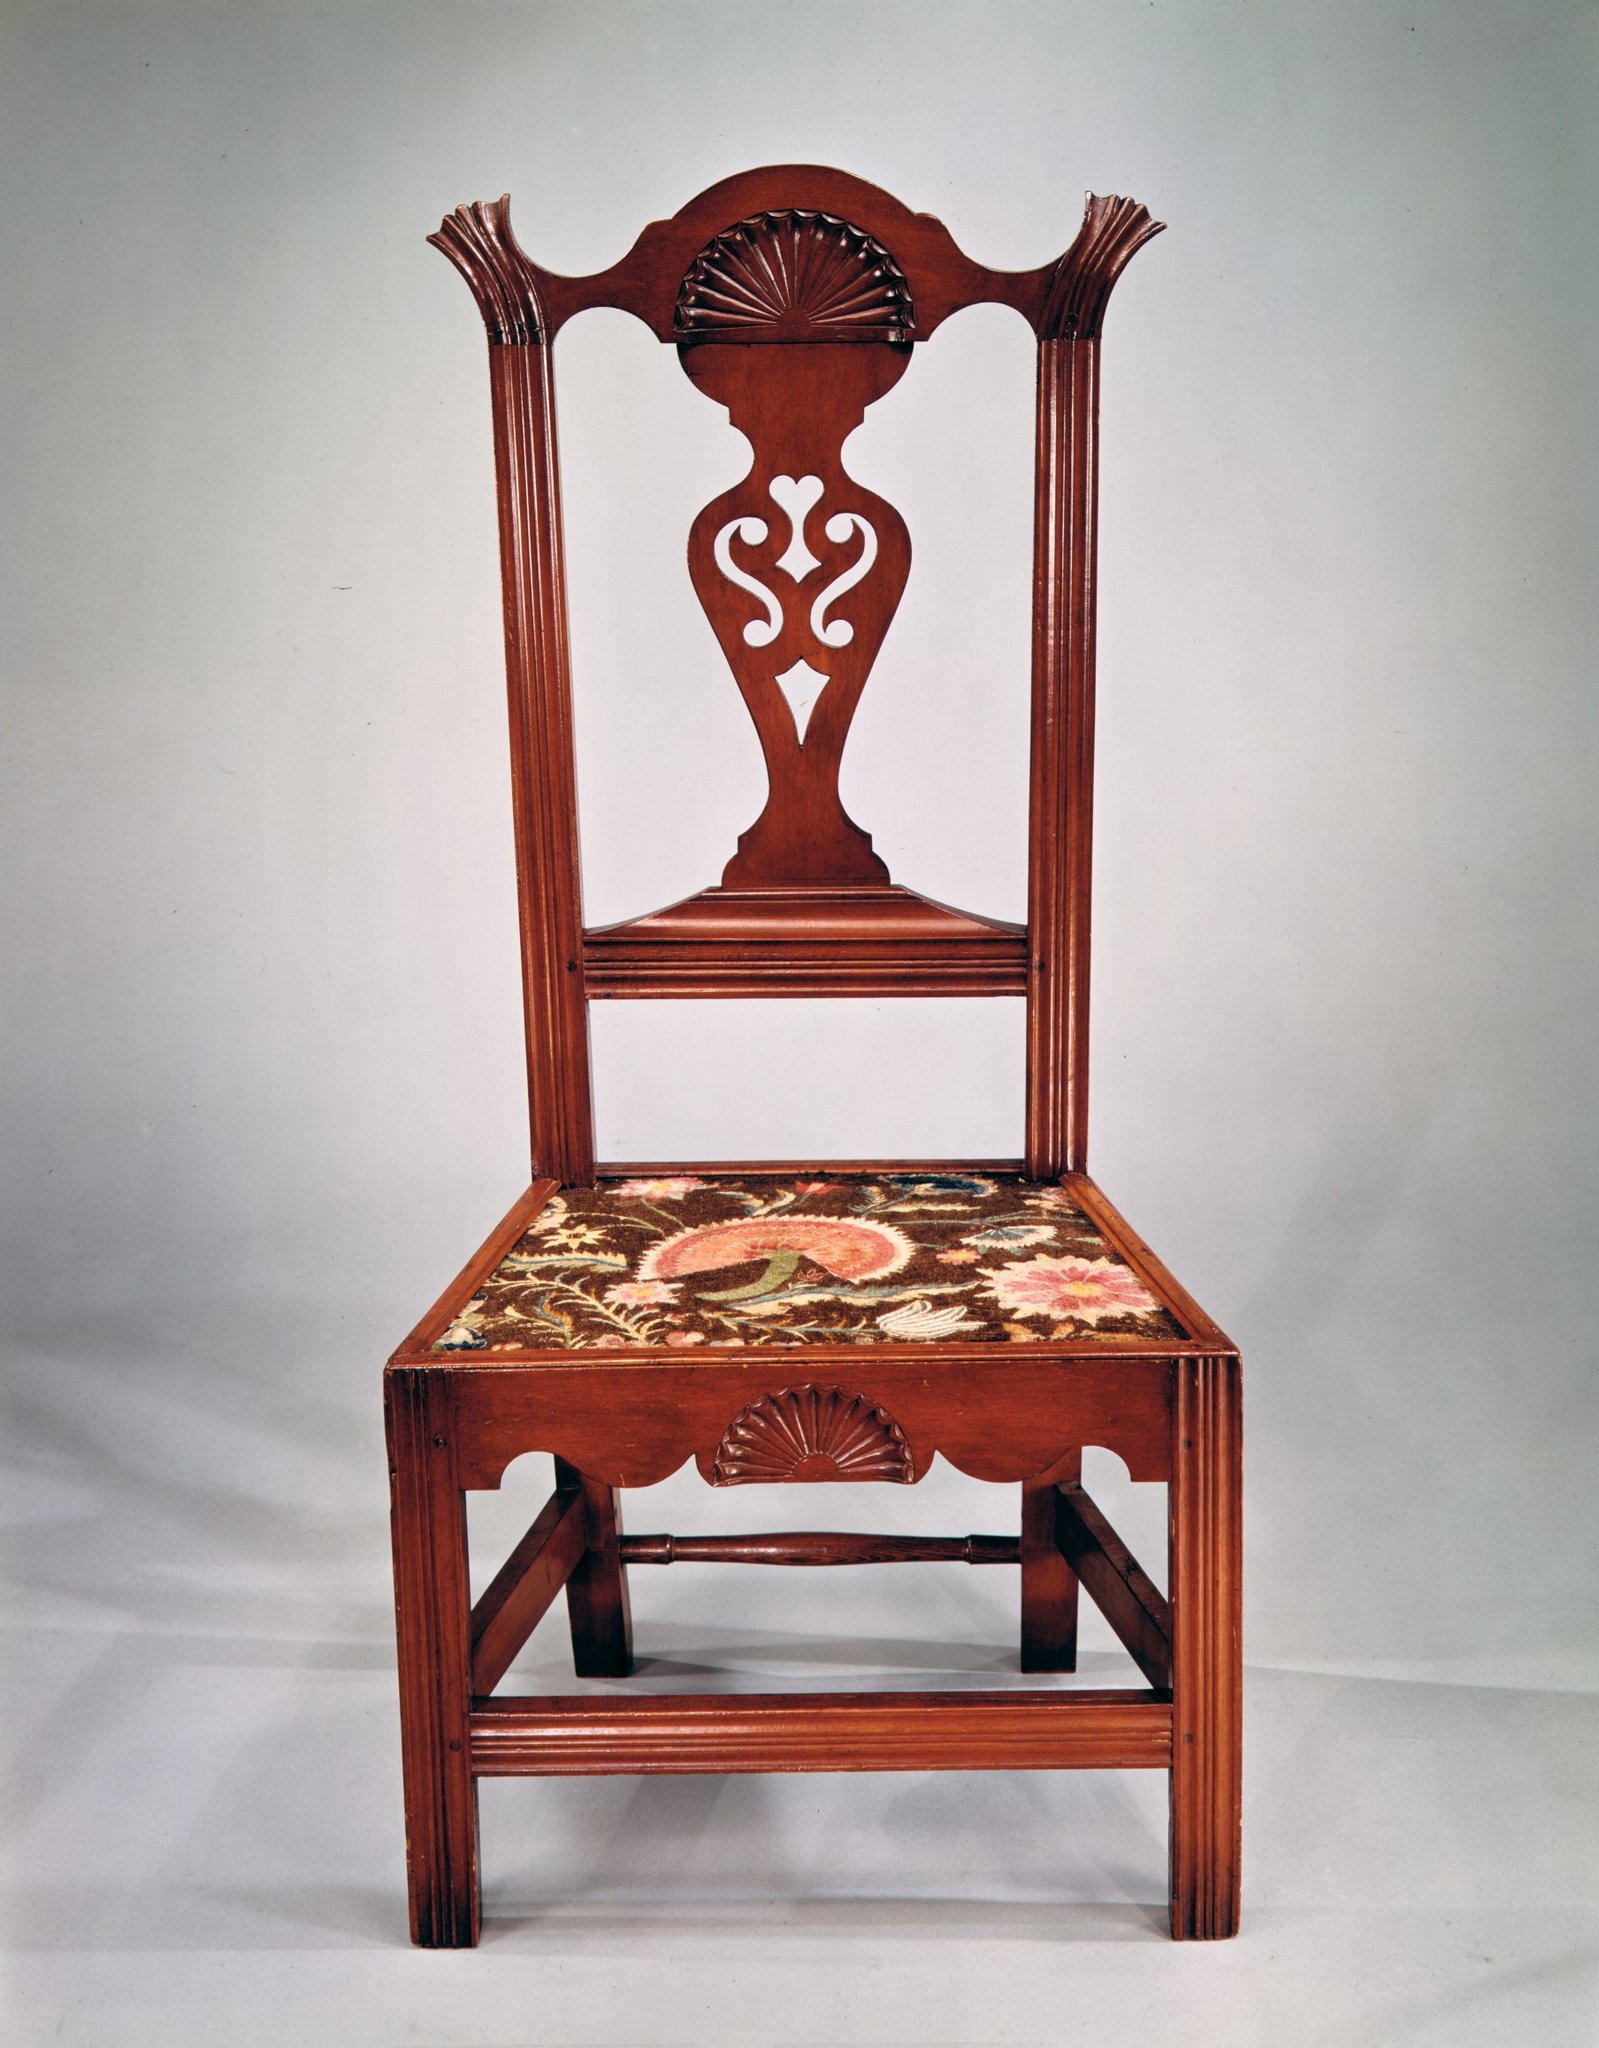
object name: side chair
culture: american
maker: samuel dunlap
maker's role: maker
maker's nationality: american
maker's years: 1786-1815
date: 1770-1790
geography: united states